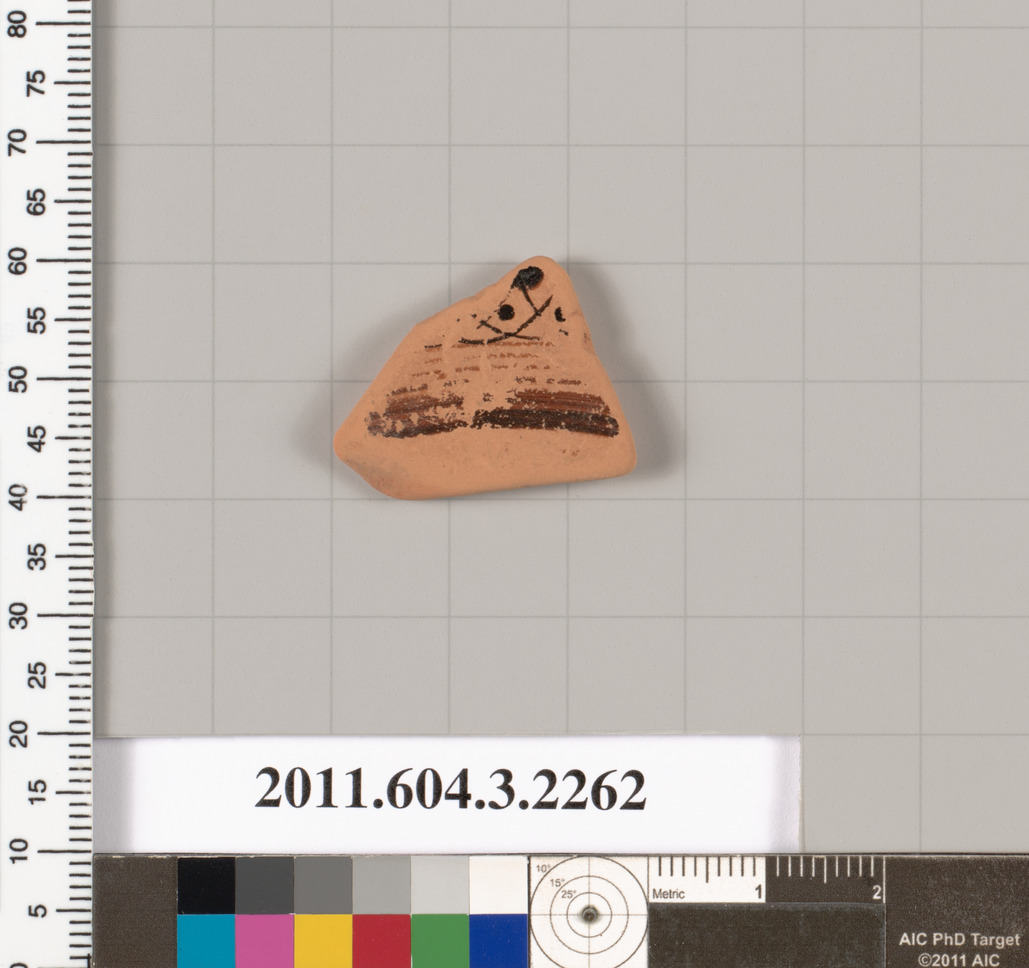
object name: kylix fragment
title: Terracotta fragment of a kylix (drinking cup)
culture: greek, attic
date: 600-401 BCE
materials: terracotta